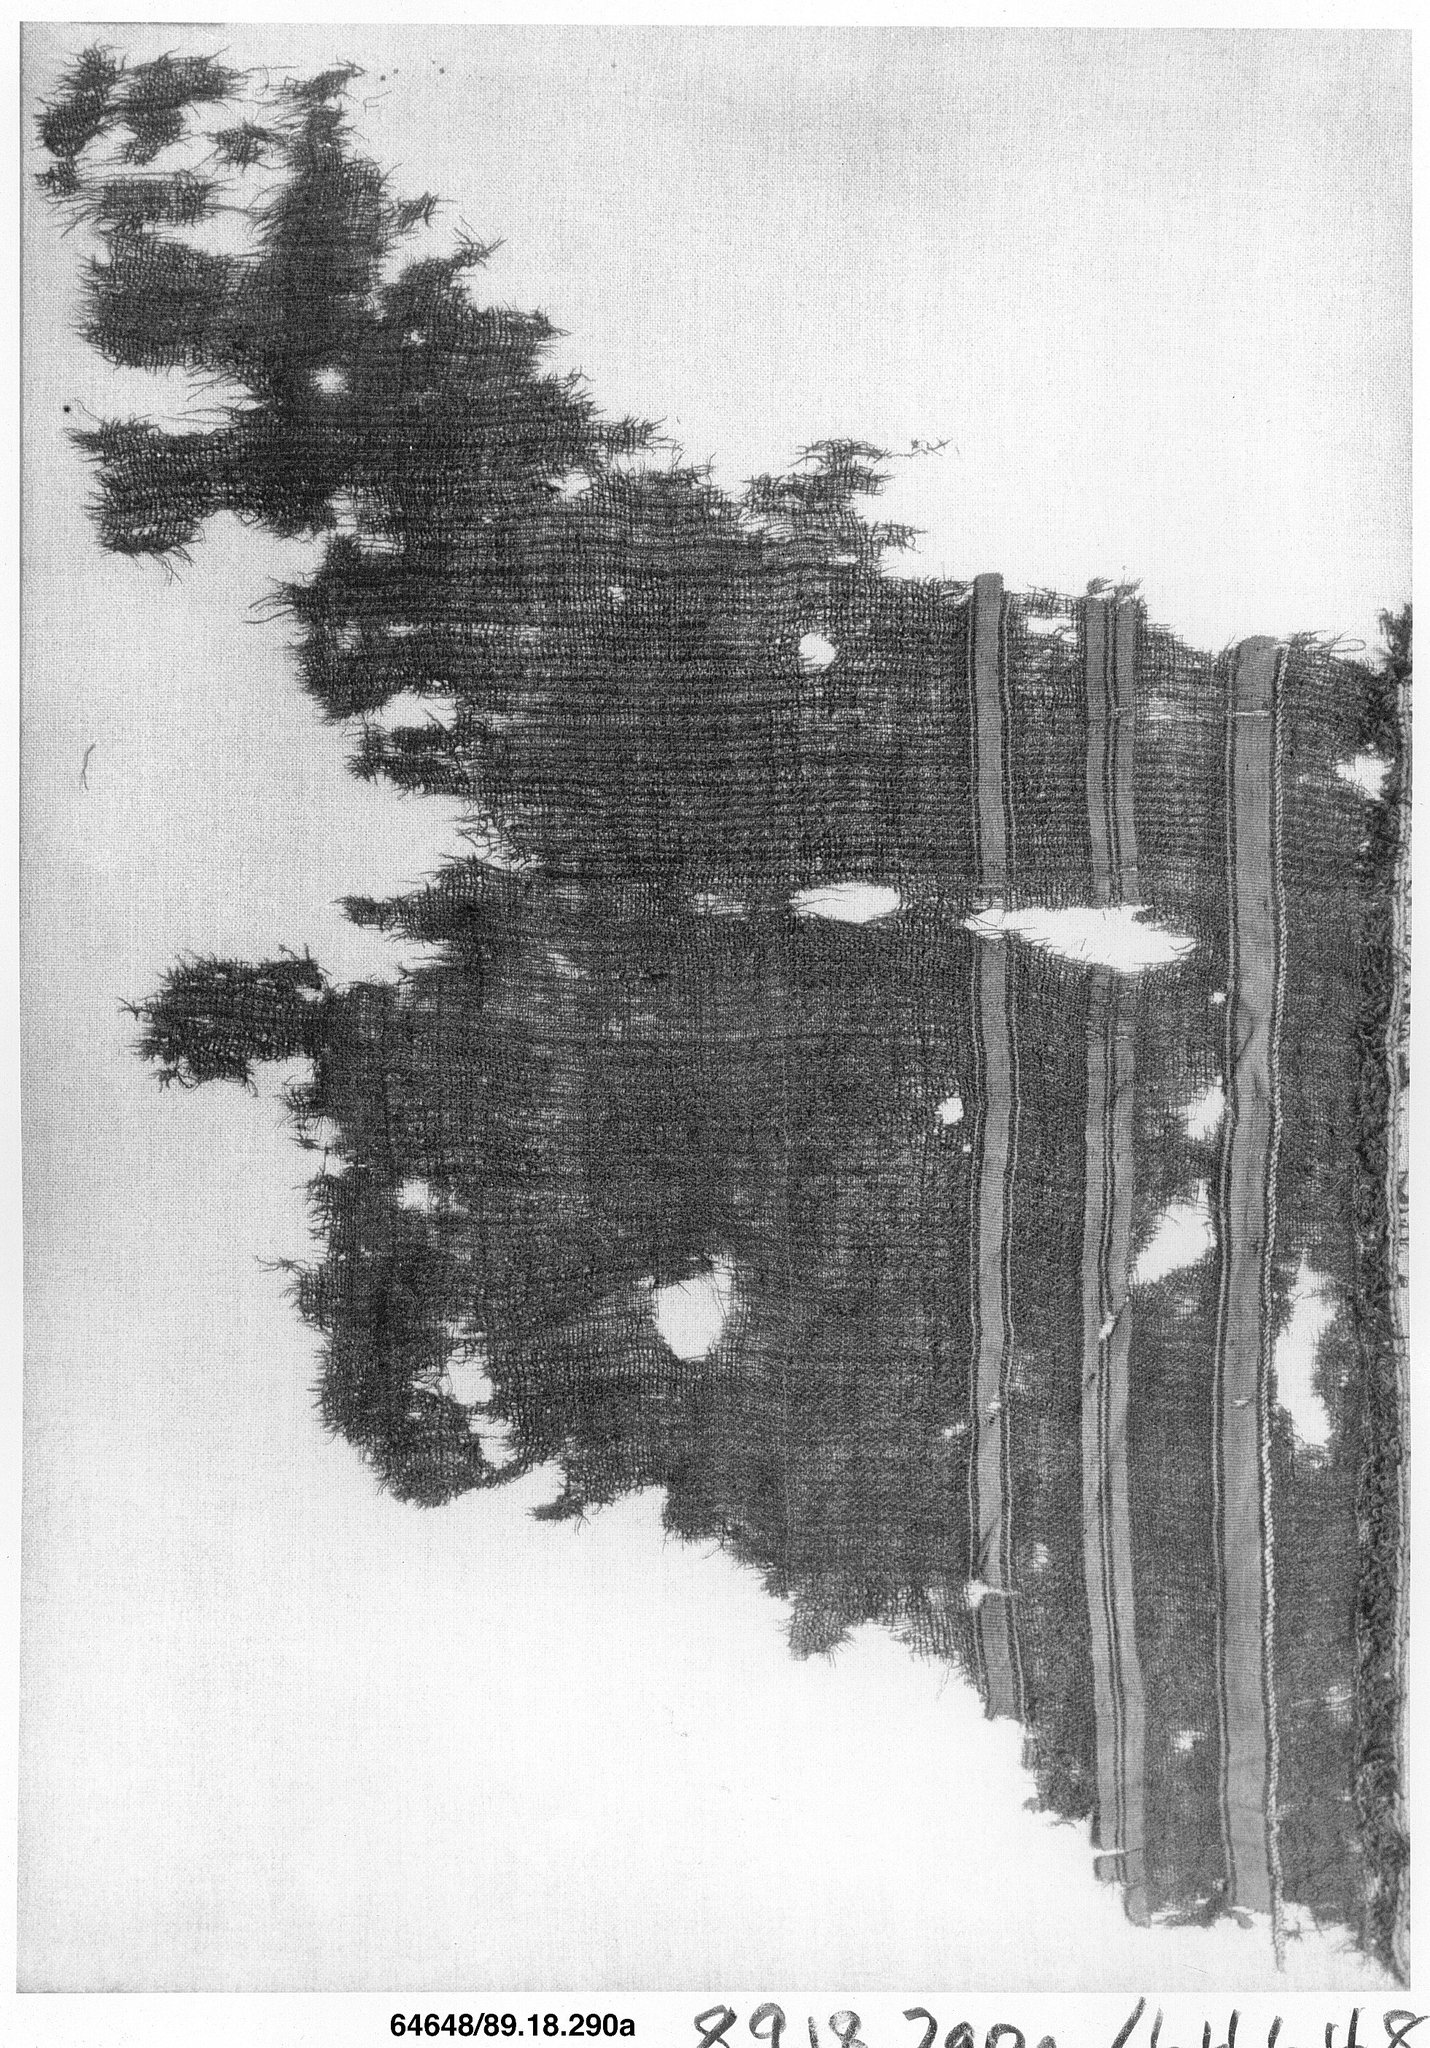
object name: textile fragment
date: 401-600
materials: linen, wool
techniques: weave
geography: egypt